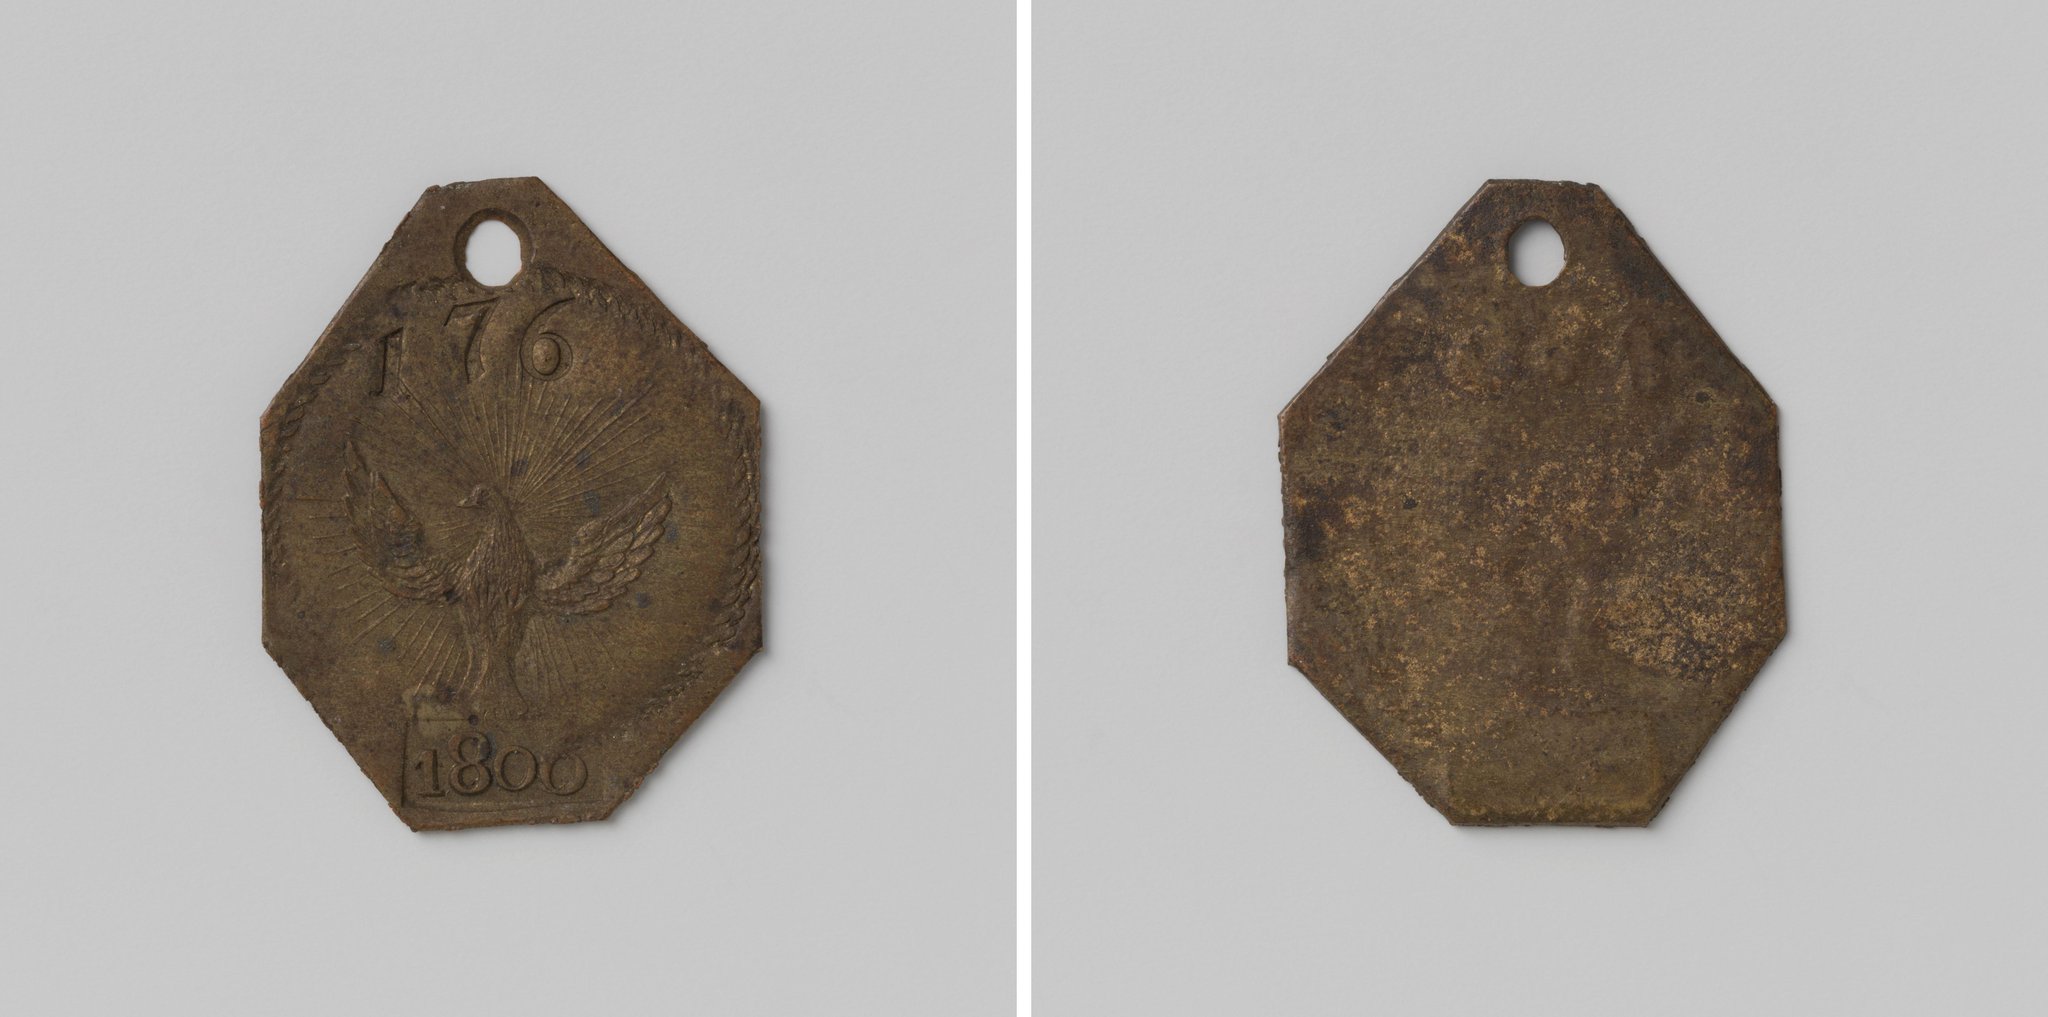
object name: hondenbelastingloodje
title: Hondenpenning van 's-Hertogenbosch met nummer 176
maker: Anonymous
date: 1806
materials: brass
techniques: striking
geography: rotterdam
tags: rotterdam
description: Eenzijdig messing achthoekig loodje met gat erin. Voorzijde: in ronde stempel: duif met gespreide vleugels en stralenkrans boven jaartal in compartiment; daarboven ingeslagen: cijfer 176. Keerzijde: blanco.